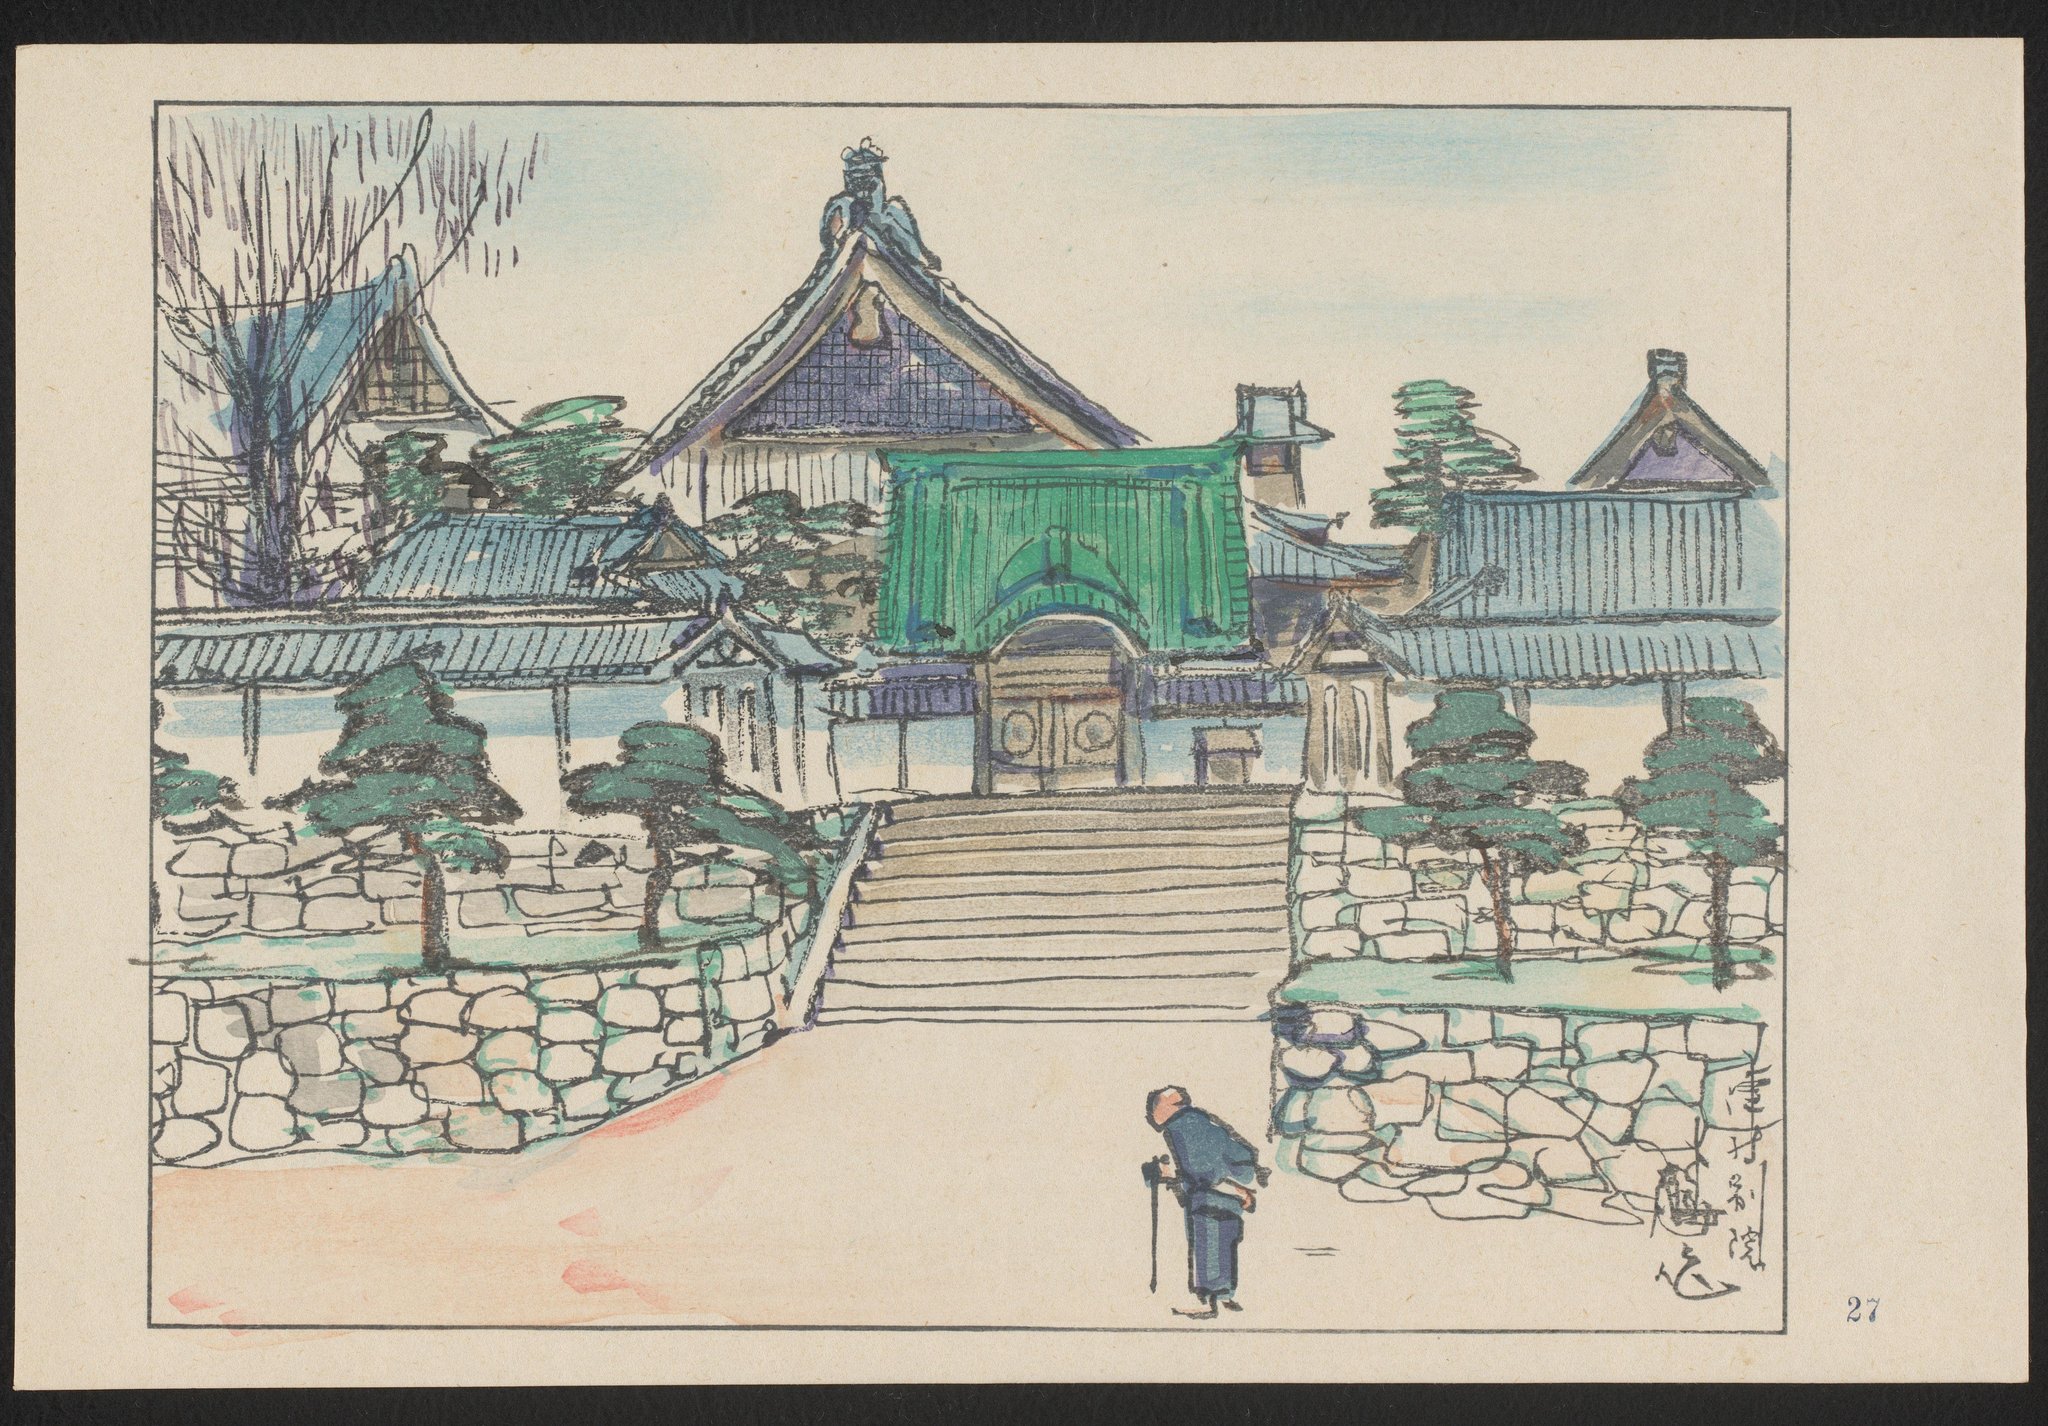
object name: print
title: Tsumura Betsuin, the agency of Nishi Honganji.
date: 1947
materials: paper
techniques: woodcut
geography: japan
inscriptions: date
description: De ingang naar de tempel Tsumura Betsuin, met op de voorgrond een oud mannetje met wandelstok.